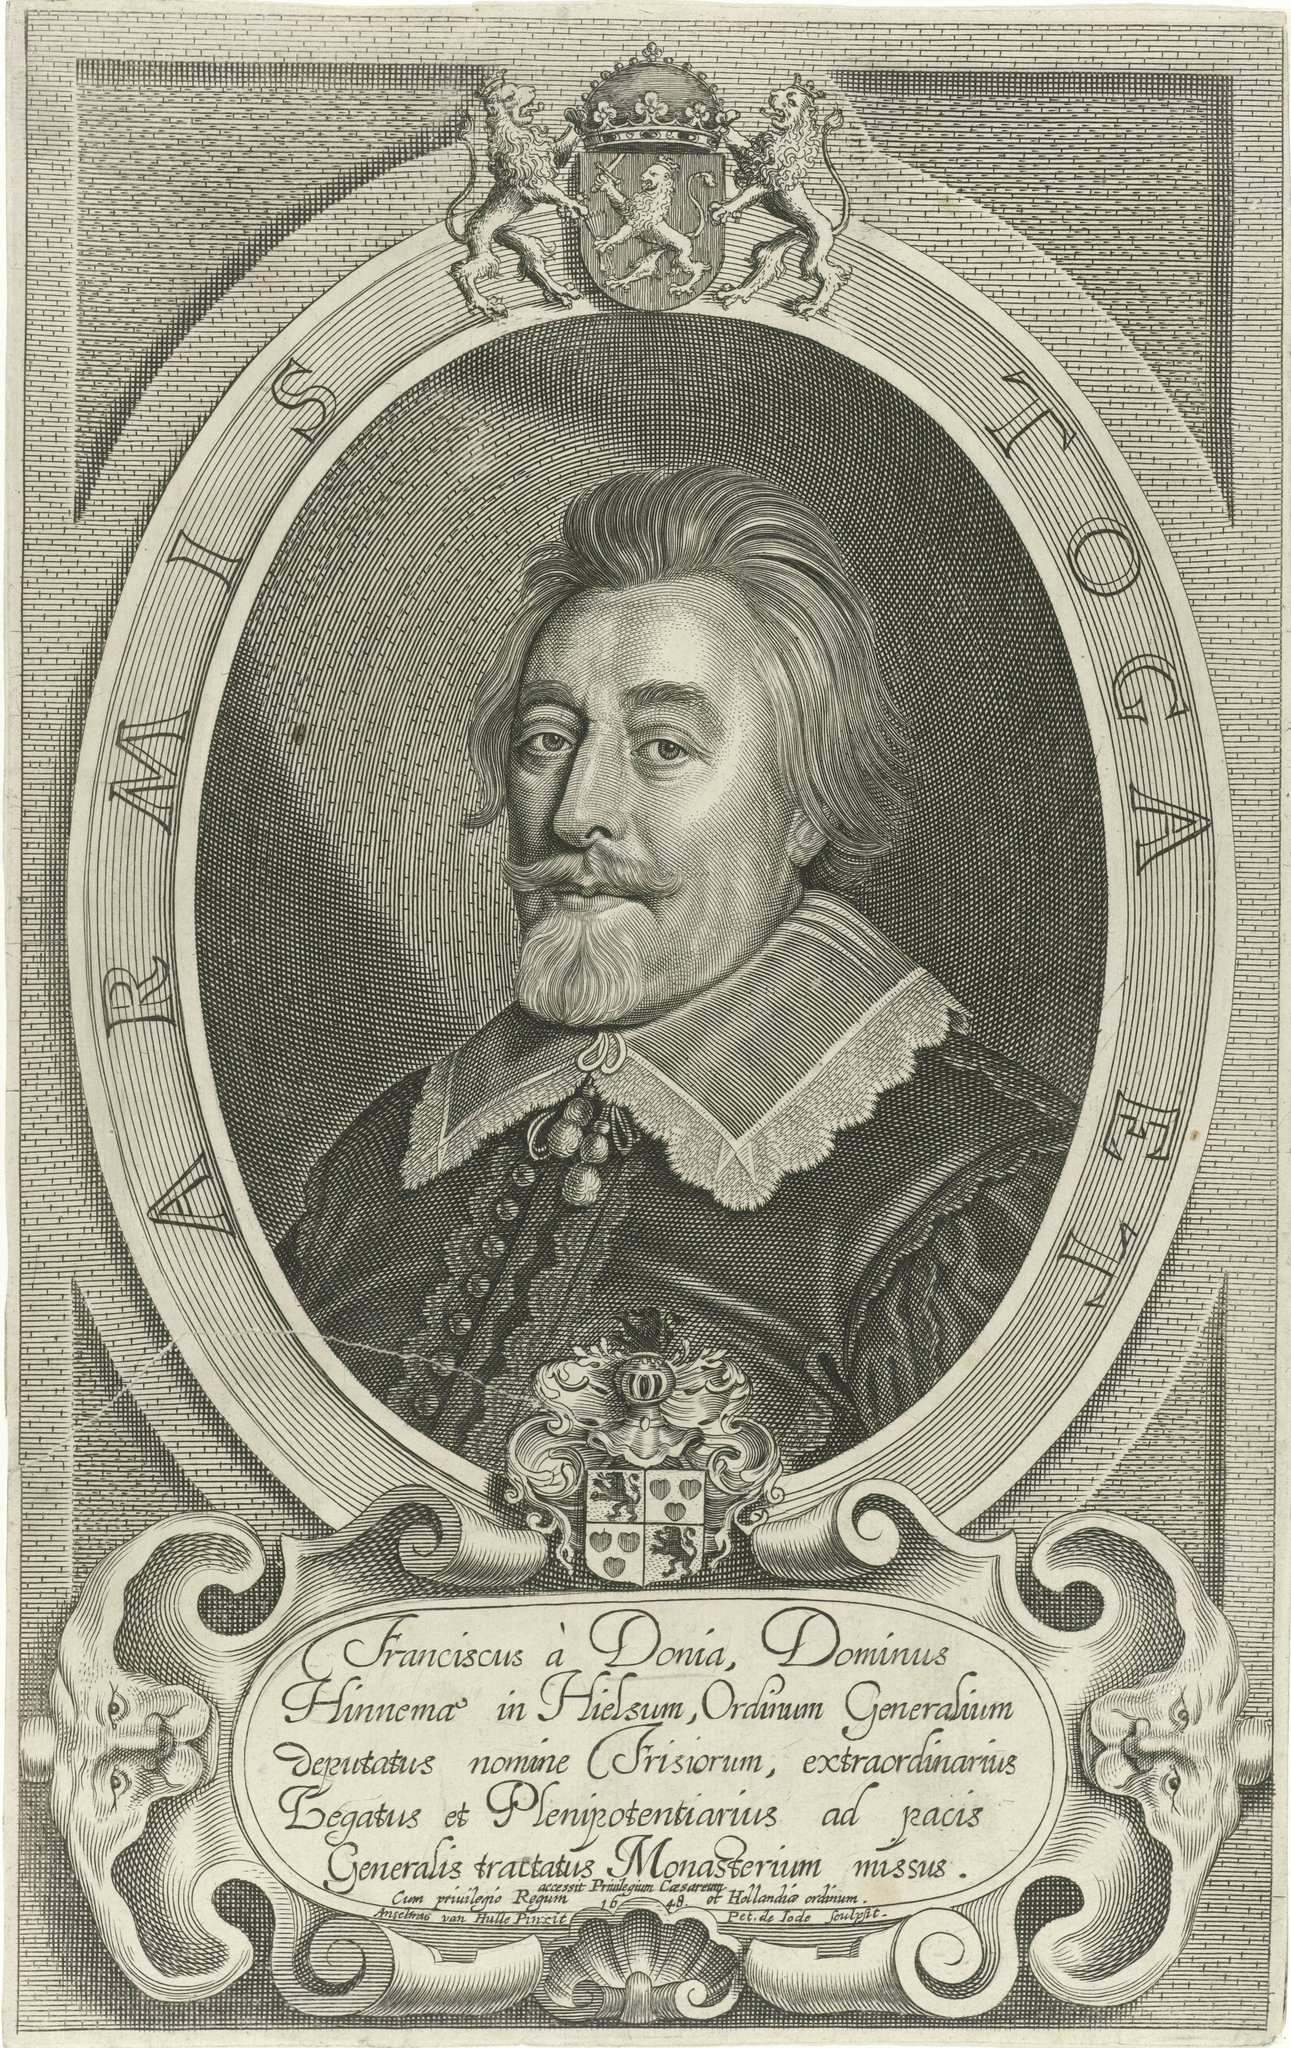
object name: print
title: Celeberrimi Legati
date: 1648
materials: paper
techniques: engraving, etching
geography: antwerp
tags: frans van donia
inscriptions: collector's mark: Lugt 2228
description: Busteportret van Frans van Donia. Het portret is gevat in een ovale omlijsting met het wapenschild van de geportretteerde en een randschrift in het Latijn. In de cartouche een vijfregelig onderschrift in het Latijn. Prent uit een serie portretten naar schilderijen van Anselmus van Hulle van alle gedelegeerden bij de vredesonderhandelingen te Münster en Osnabrück.